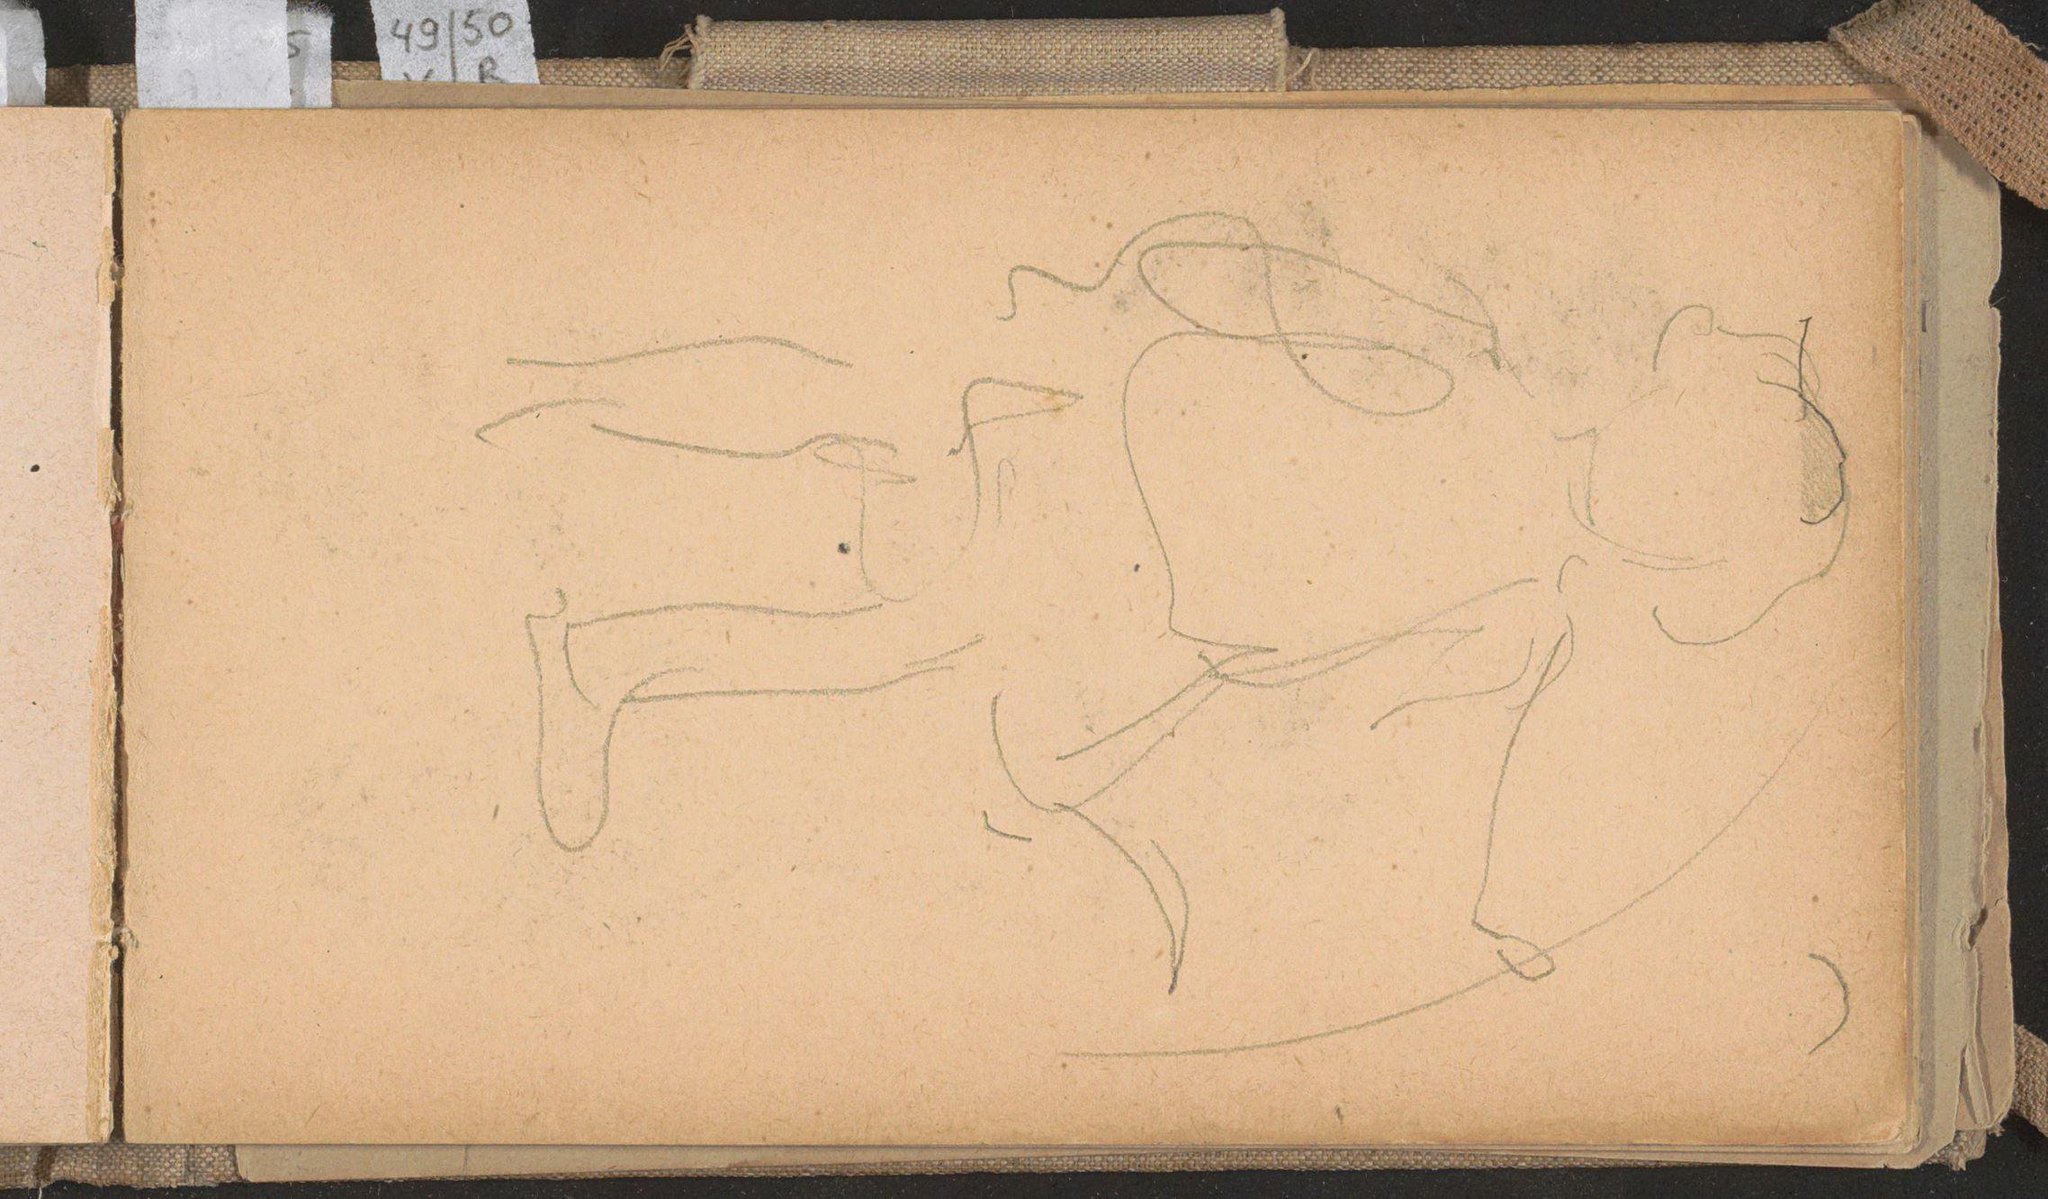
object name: sketchbook leaf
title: Staand meisje met opgeheven arm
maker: antoon derkinderen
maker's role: draughtsman, painter, print maker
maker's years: 1859-1925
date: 1892-1901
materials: paper, pencil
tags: girl (child between toddler and youth)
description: Blad 35 recto uit een schetsboek met 51 bladen.